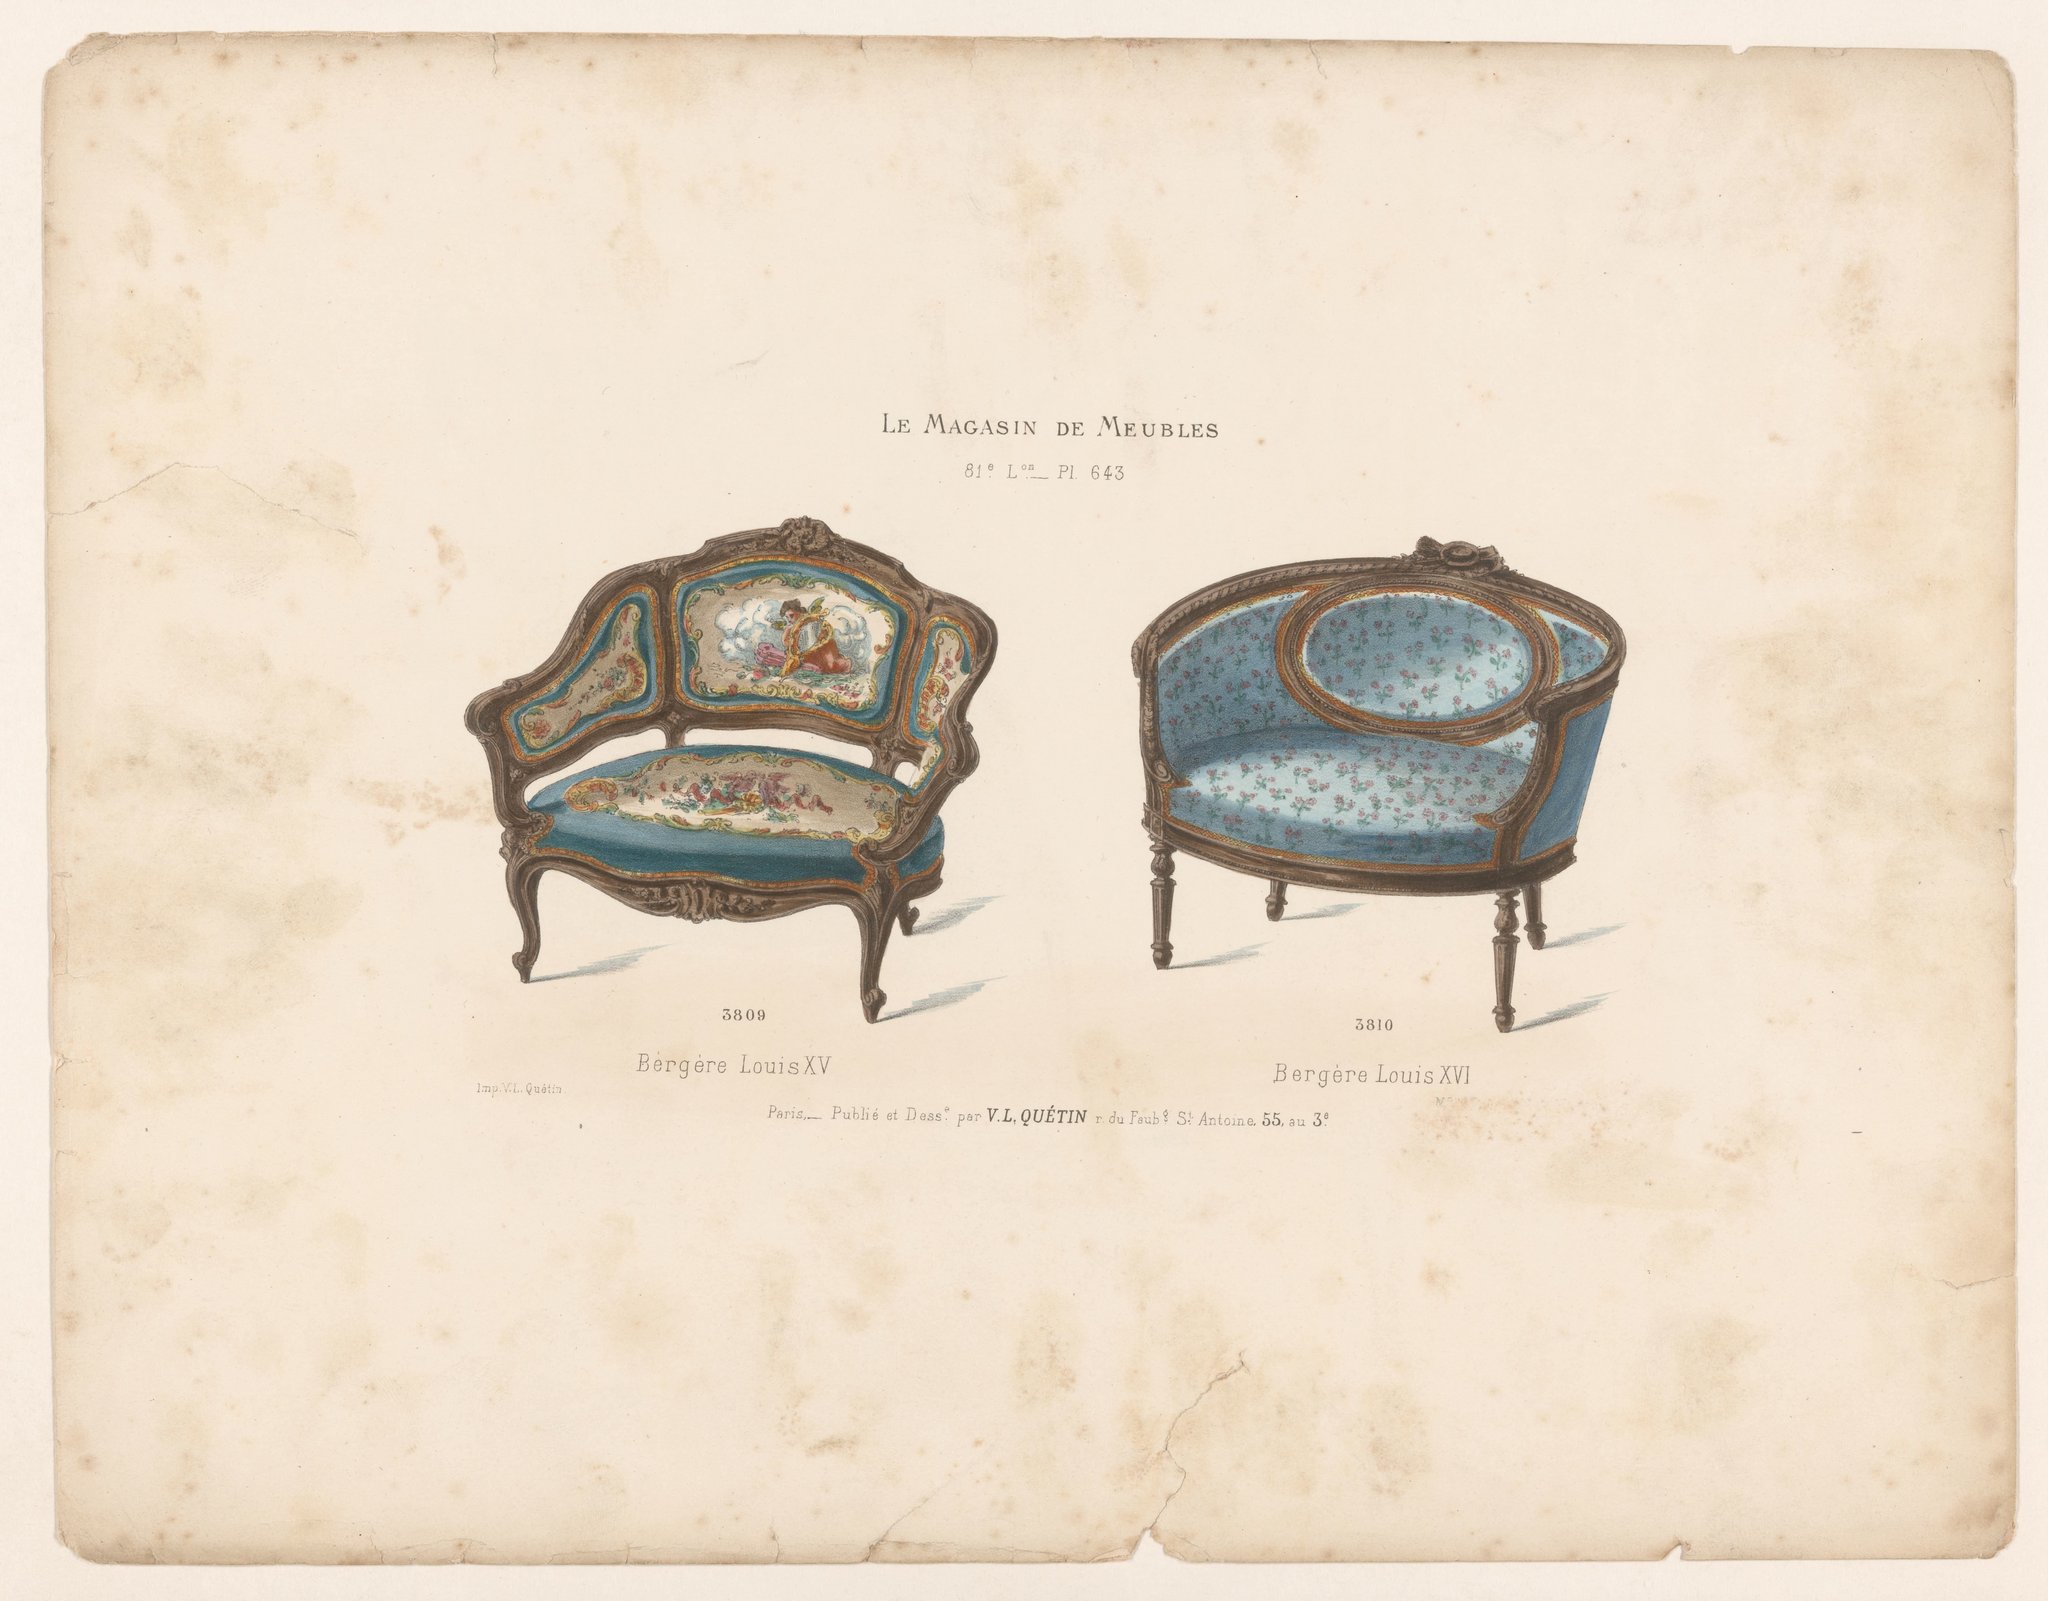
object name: print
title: Twee fauteuils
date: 1878-1904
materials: paper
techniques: hand coloring, lithograph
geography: paris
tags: seating furniture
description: Twee fauteuils in de stijlen Lodewijk XV en Lodewijk XVI. Prent uit 81e Livraison.